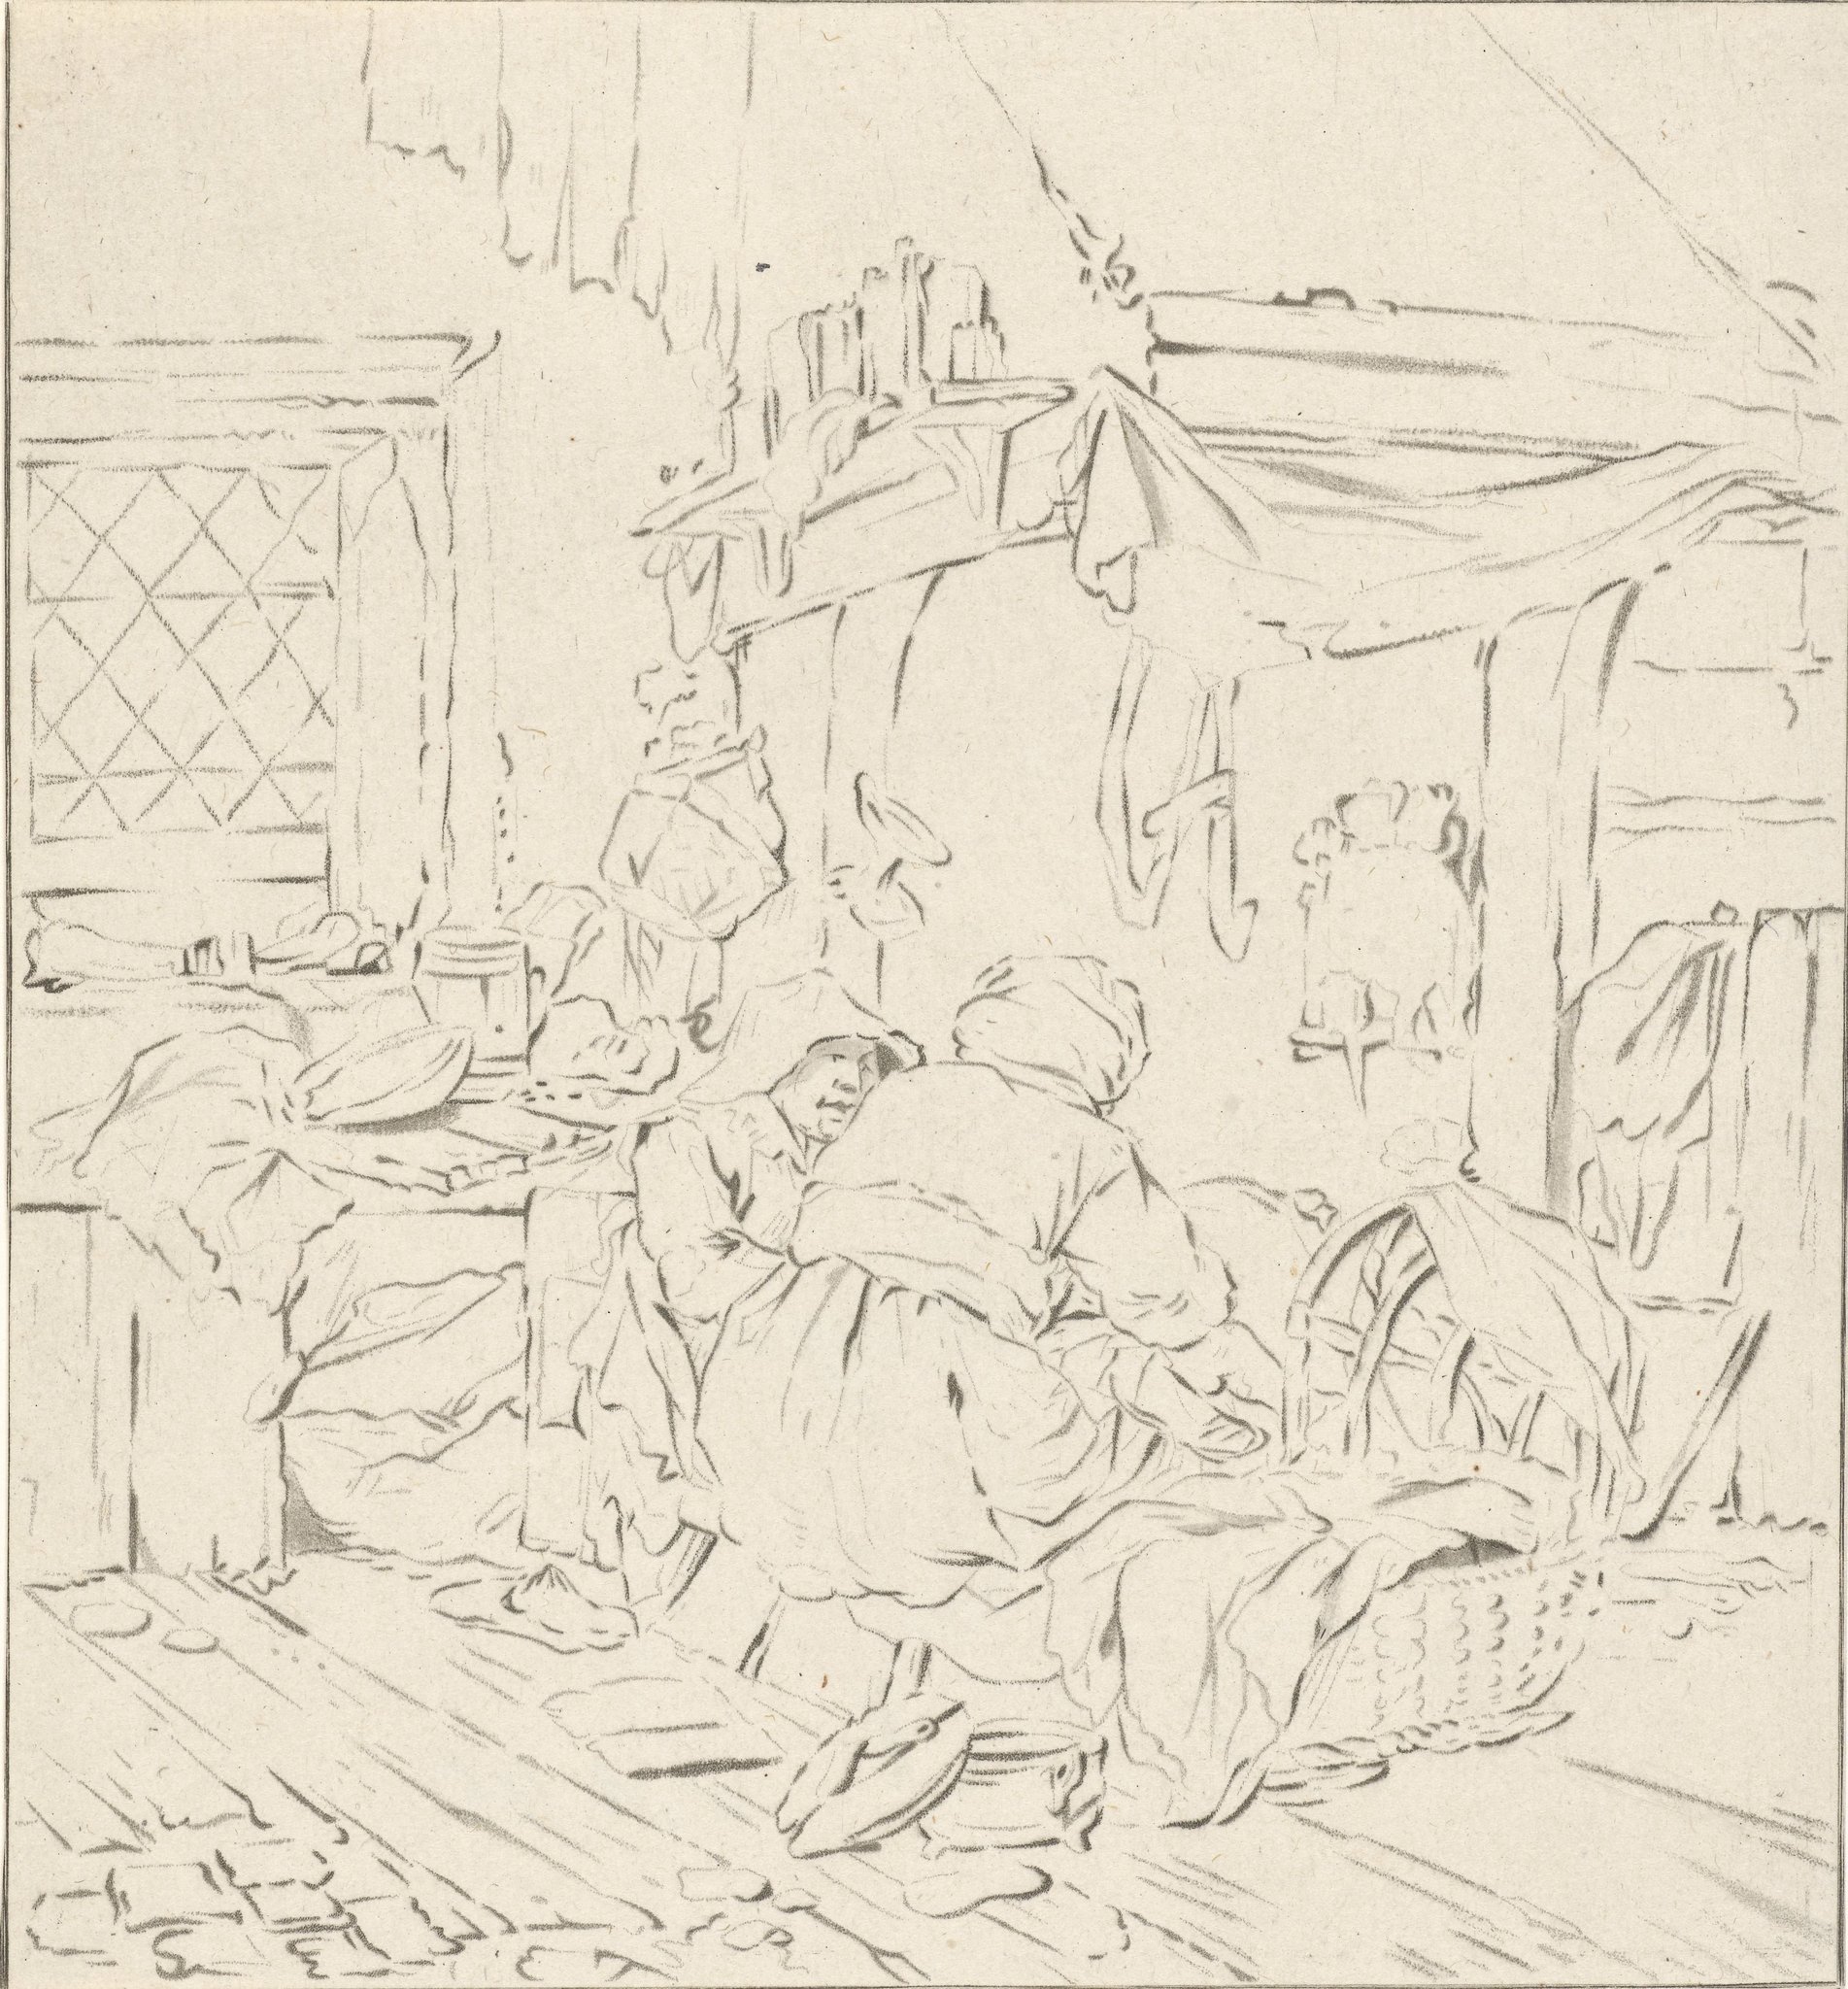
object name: print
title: Boereninterieur met twee vrouwen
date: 1772-1787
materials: paper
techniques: etching, roulette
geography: amsterdam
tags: open hearth, fire-place, interior of the house, cradle, crib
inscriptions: collector's mark: Lugt 240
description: Interieur met twee vrouwen bij een wieg.